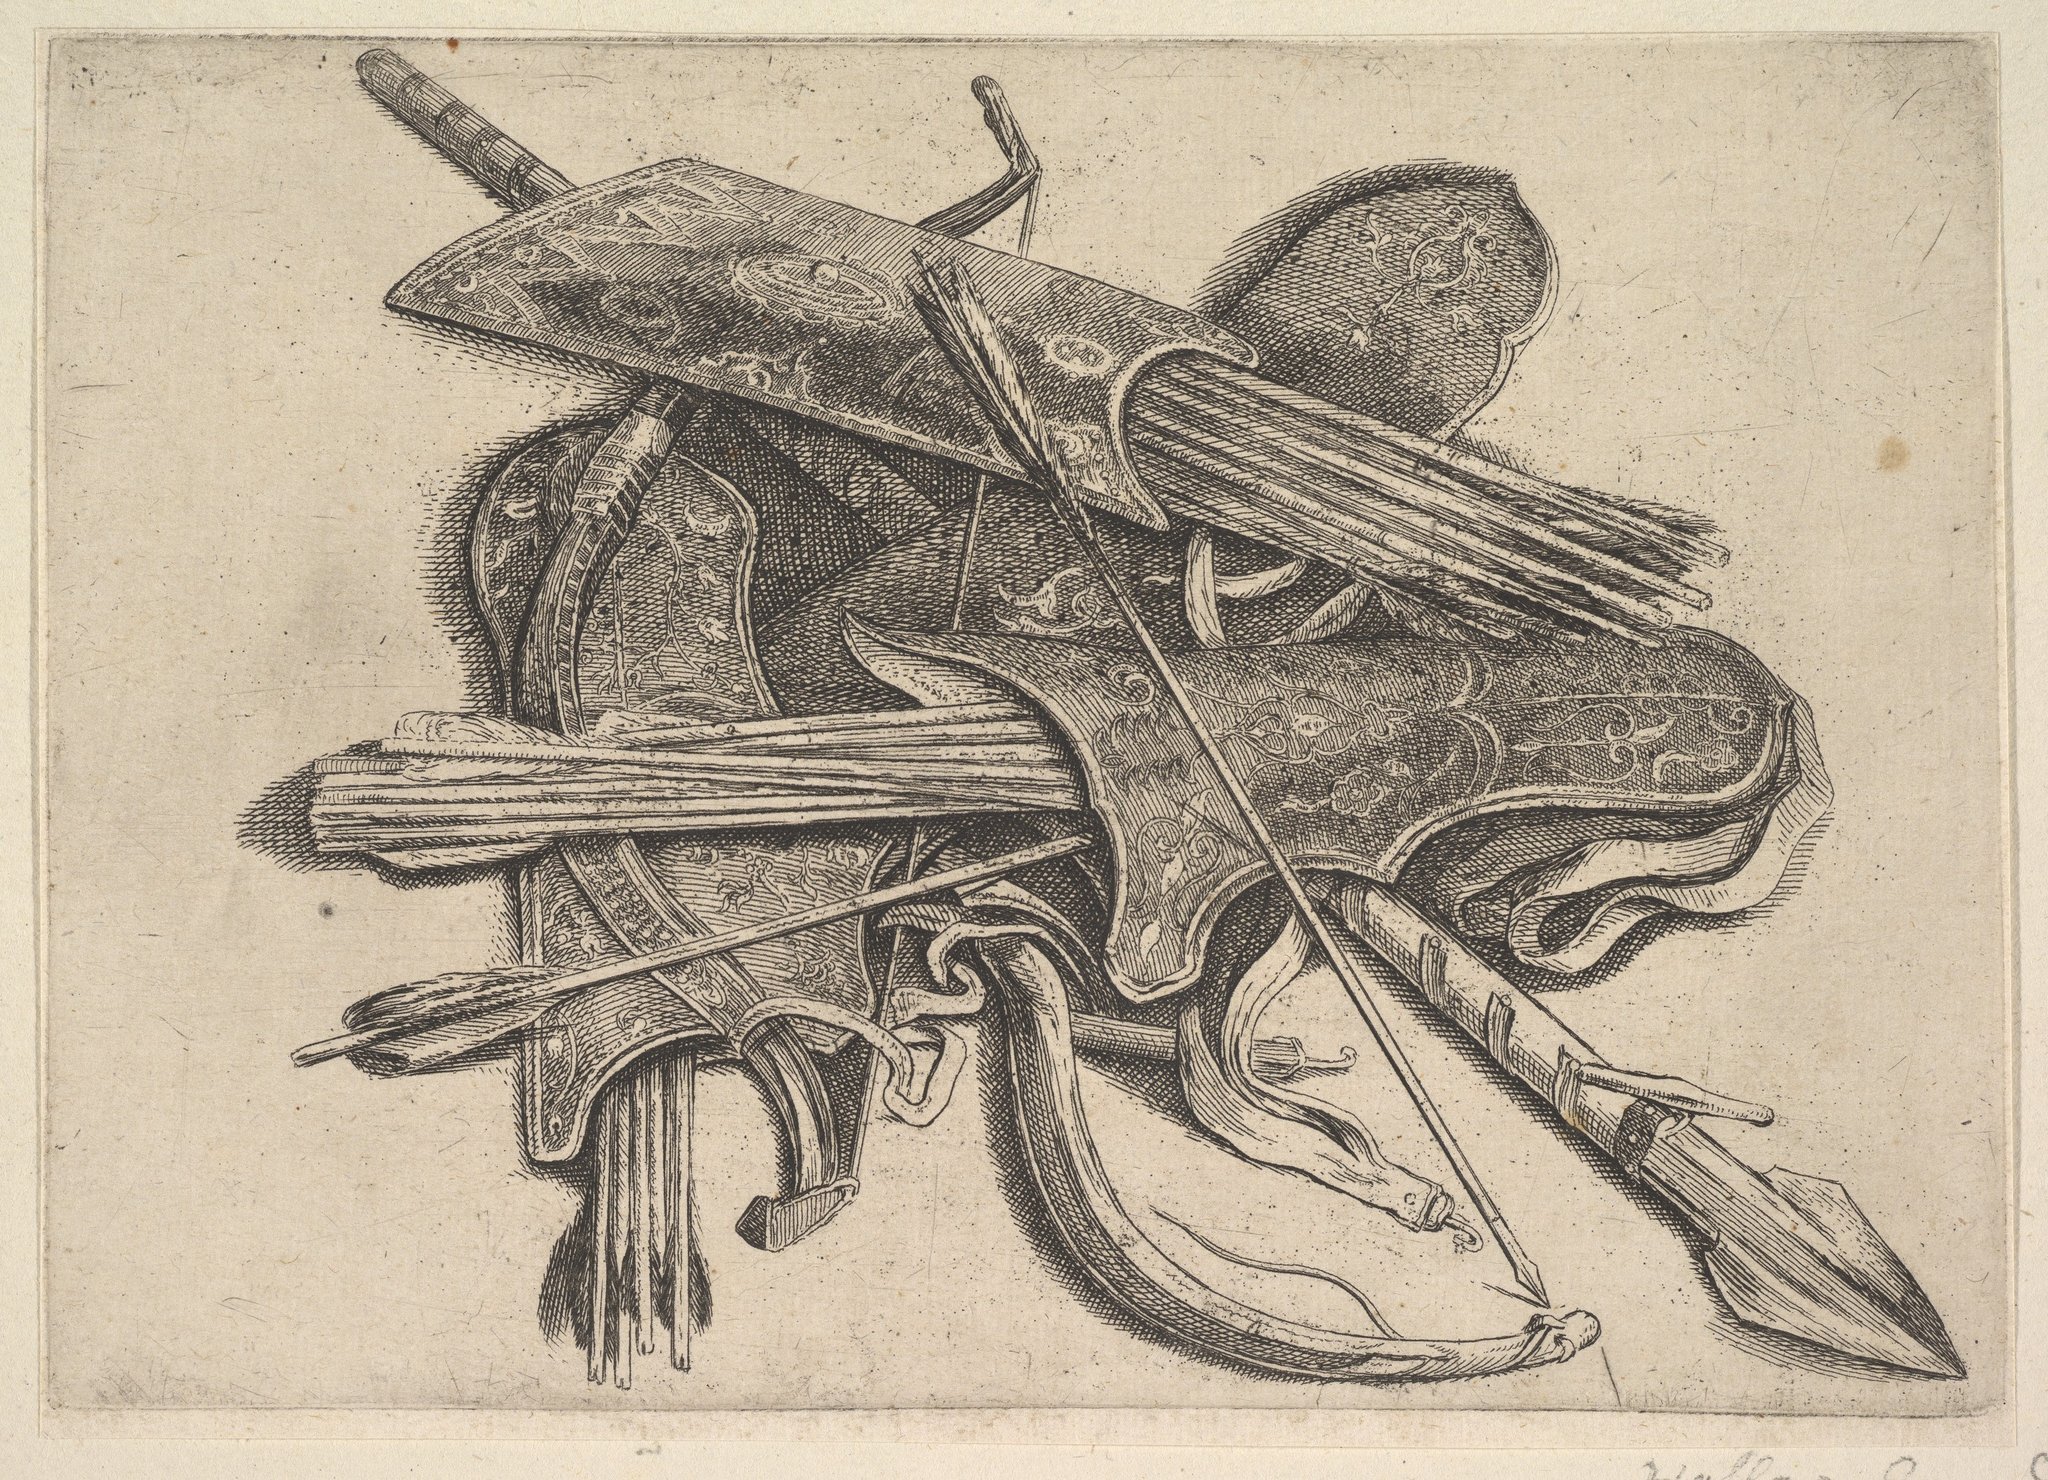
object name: print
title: Bows, quivers and a spear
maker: wenceslaus hollar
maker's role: artist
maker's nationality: bohemian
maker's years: 1607-1677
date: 1647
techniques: etching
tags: arrows,bow and arrow,spears